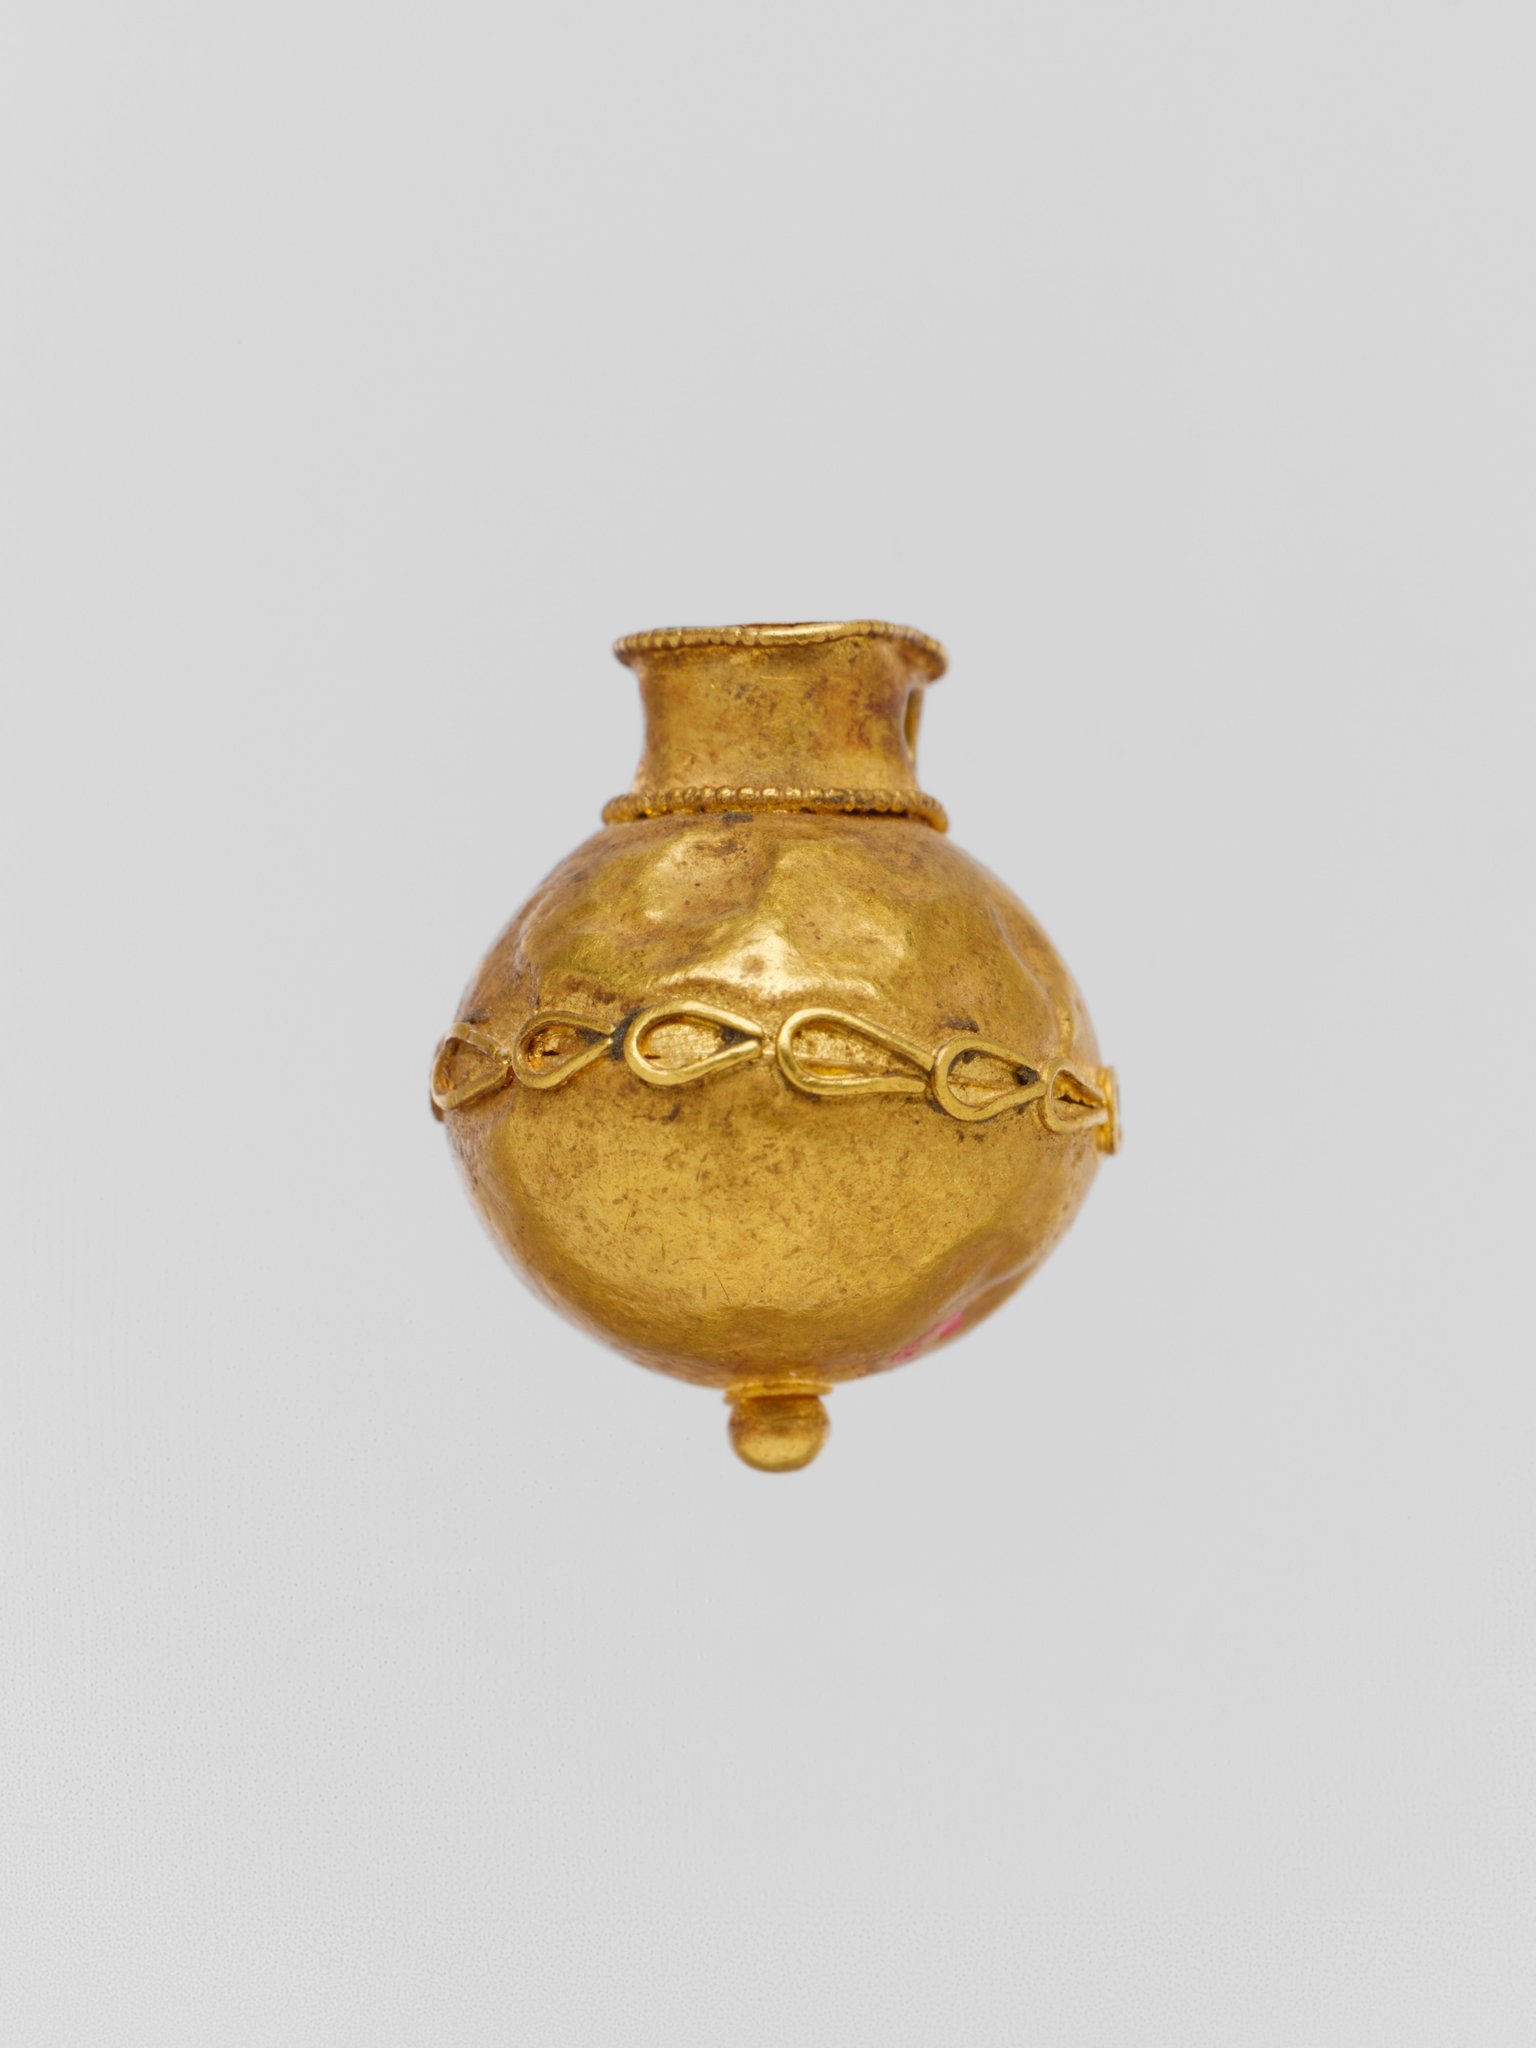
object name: pendant in the form of a vase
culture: greek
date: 500-301 BCE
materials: gold